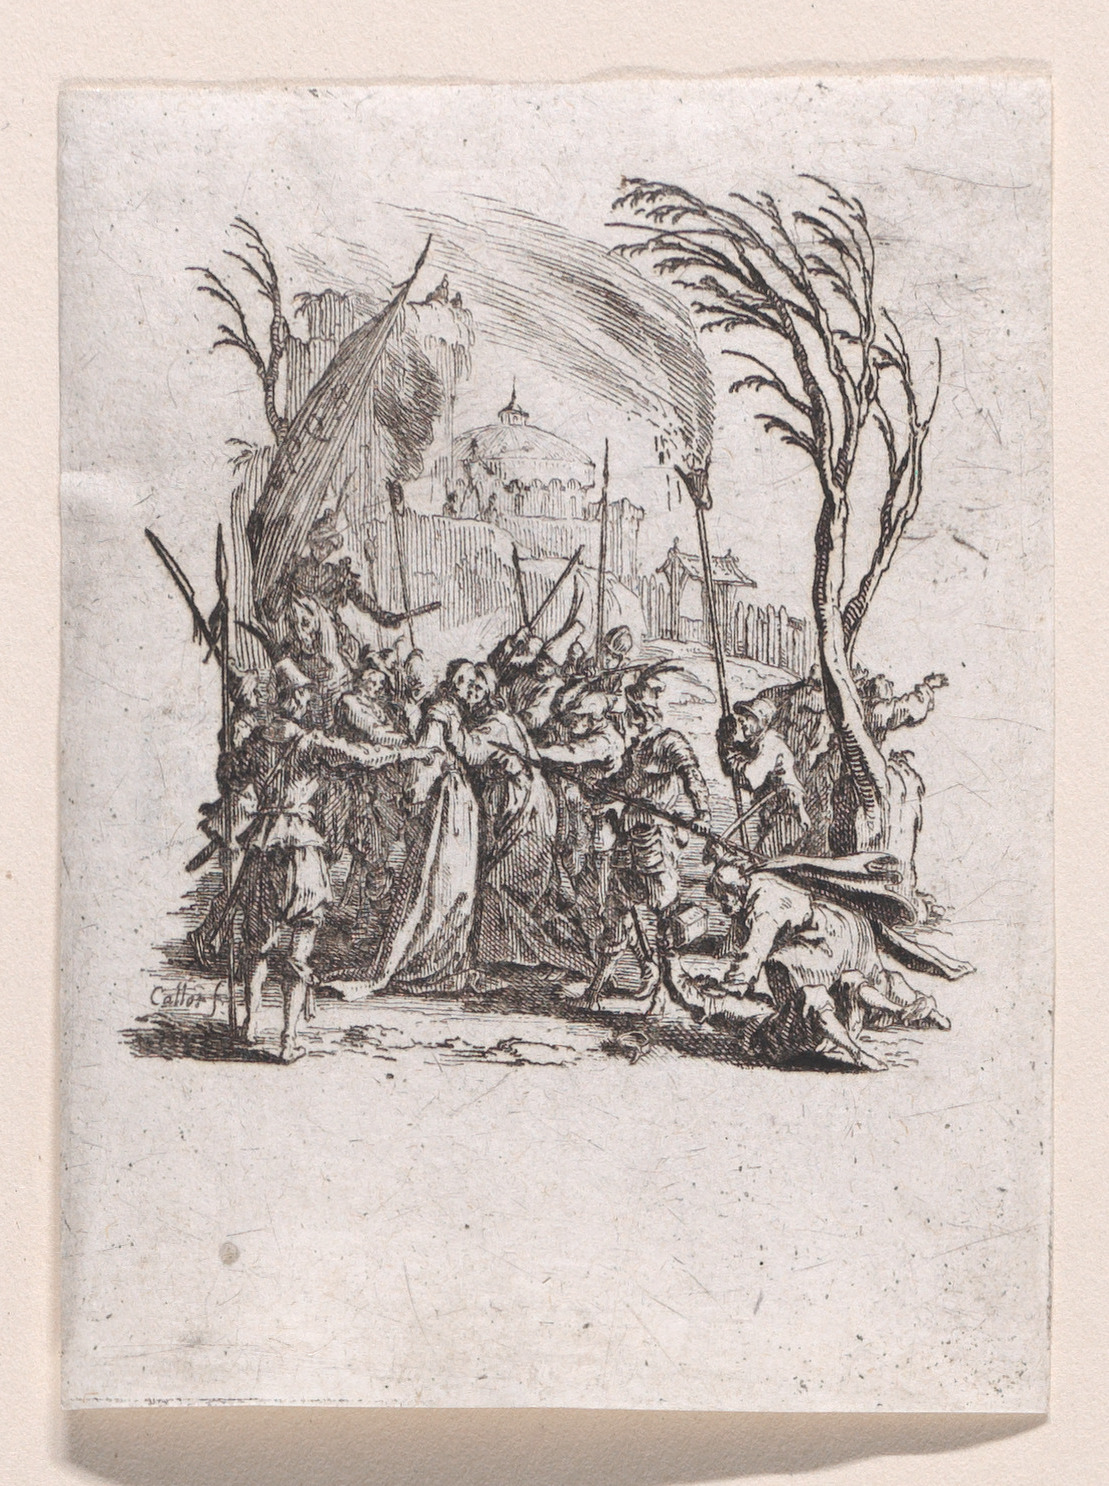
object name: print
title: Jésus est Livré aux Juifs (Jesus is Delivered to the Jews), from "La Petite Passion" (The Little Passion)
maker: jacques callot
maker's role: artist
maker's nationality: french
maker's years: 1592-1635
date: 1624-1625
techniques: etching